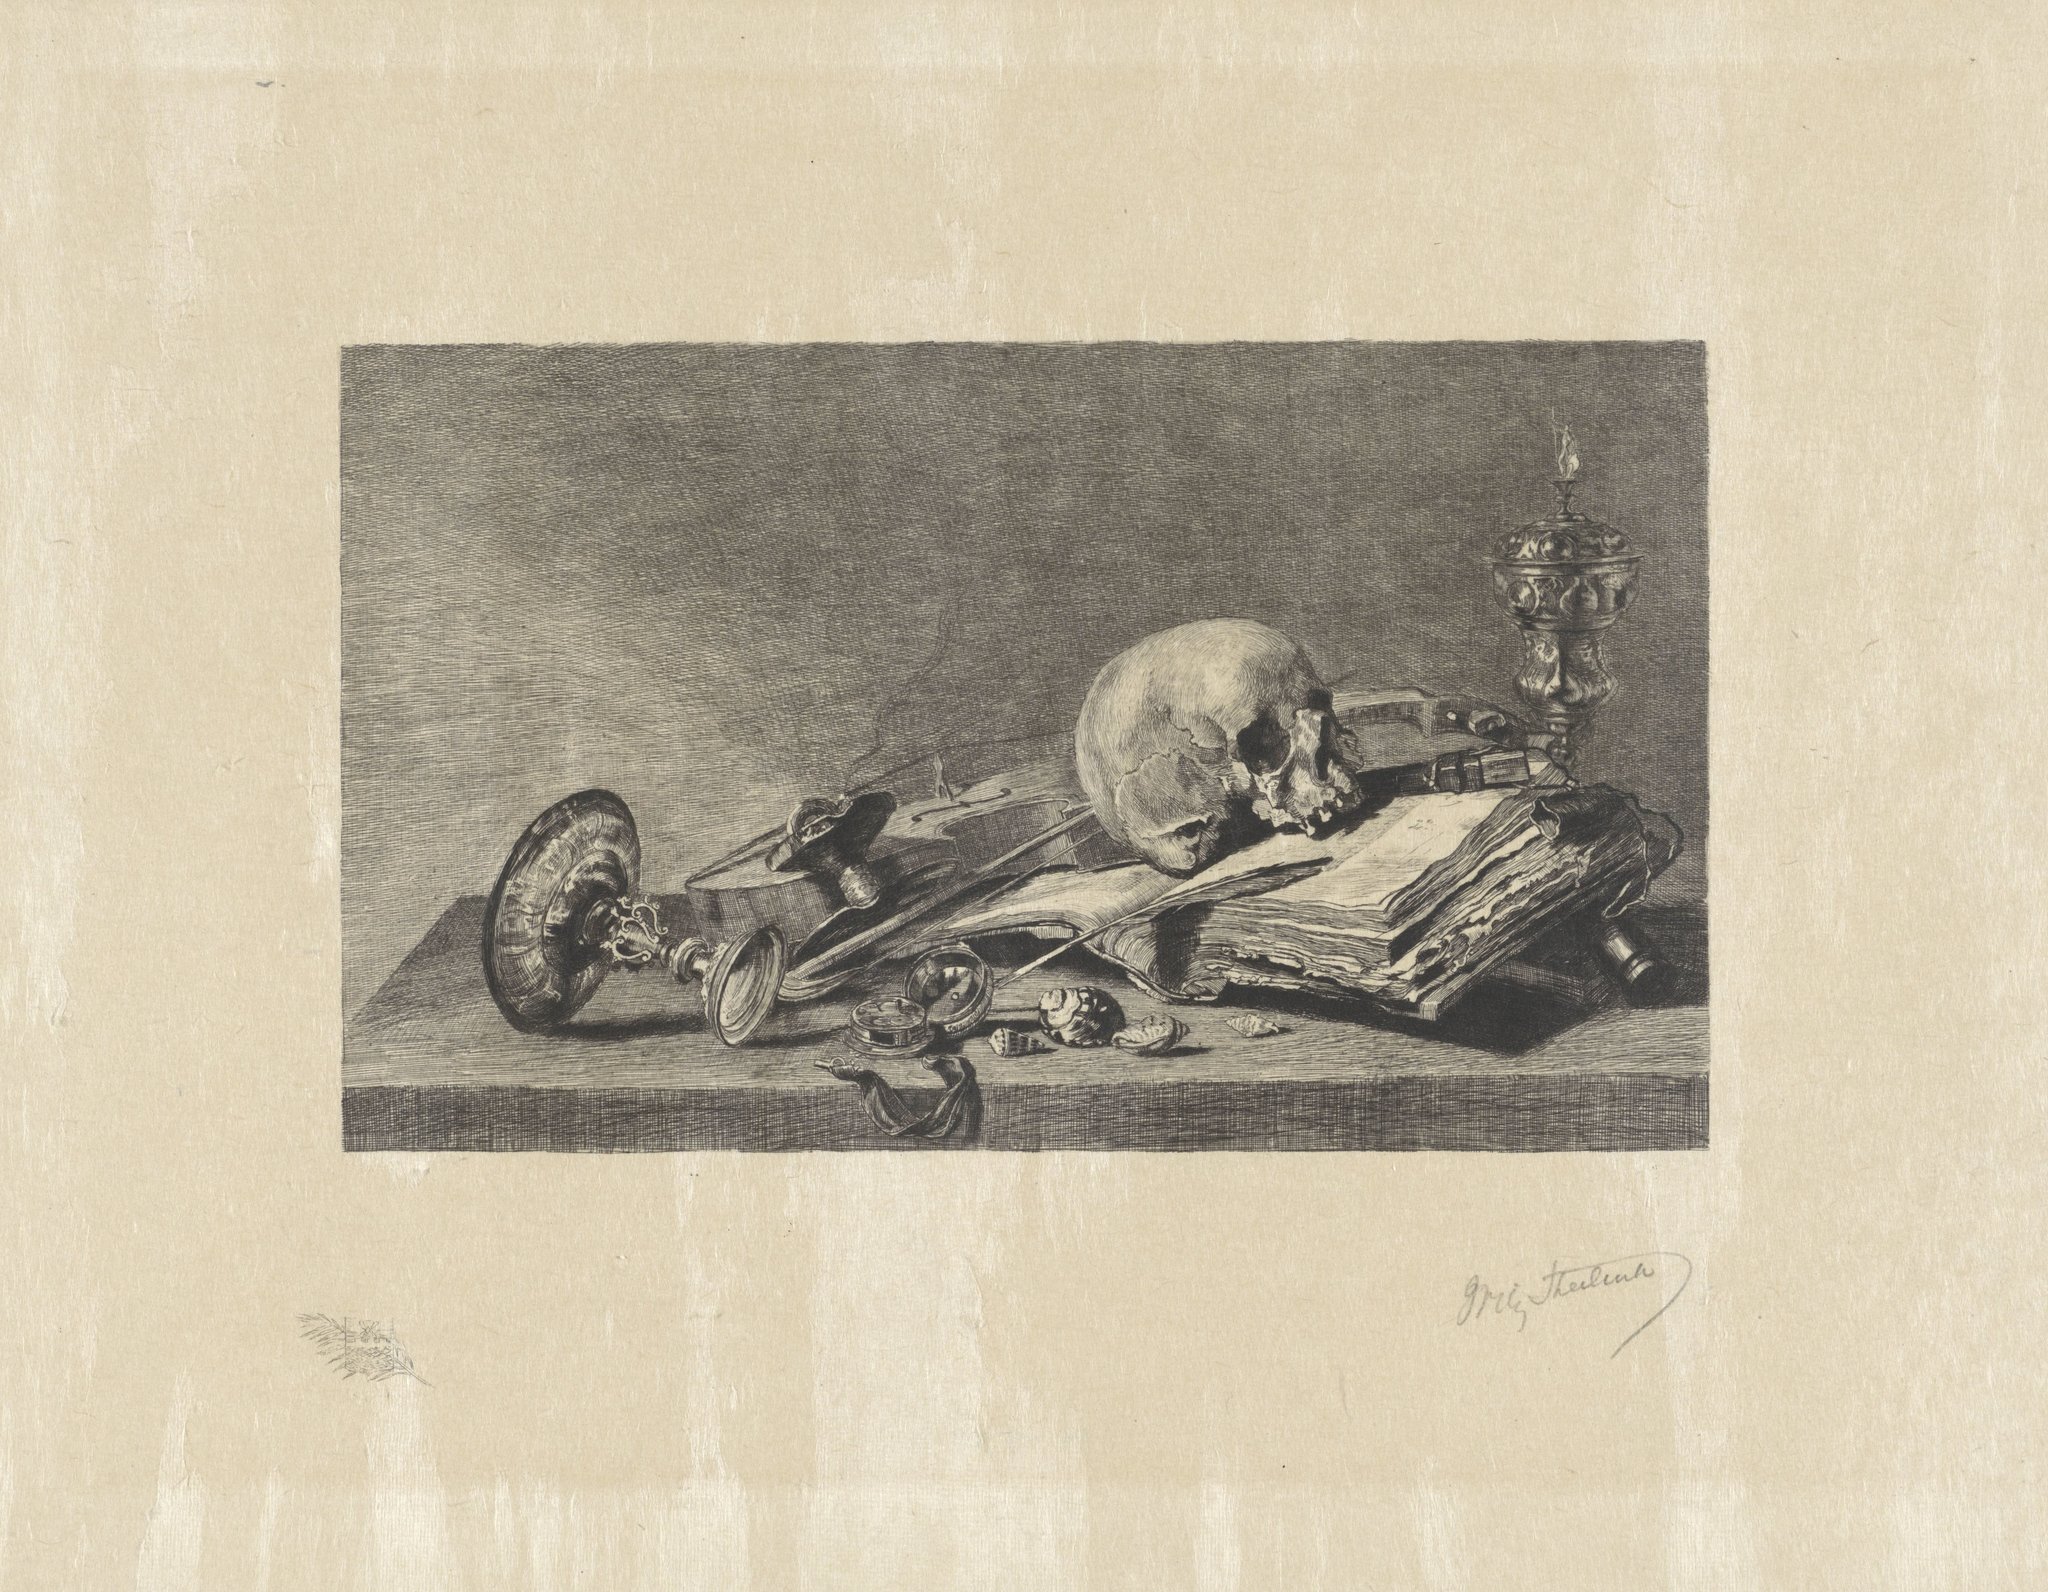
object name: print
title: Vanitas stilleven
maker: willem steelink (ii)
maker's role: draughtsman, print maker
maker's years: 1856-1928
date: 1888-1891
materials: paper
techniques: etching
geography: netherlands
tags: skull as symbol of 'vanitas', 'vanitas' still life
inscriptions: collector's mark: Lugt 2228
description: Prent mogelijk gebruikt in: Oude kunst in Nederland : etsen van Wilm. Steelink, naar schilderijen uit de kabinetten van A. Bredius, A.J. Enschedé, J.P. Six, P.H. Siz, H.A. Steengracht van Duivenvoorde, Victor de Stuers en andere verzamelingen. Amsterdam: Van Holkema & Warendorf, 1888-1891.